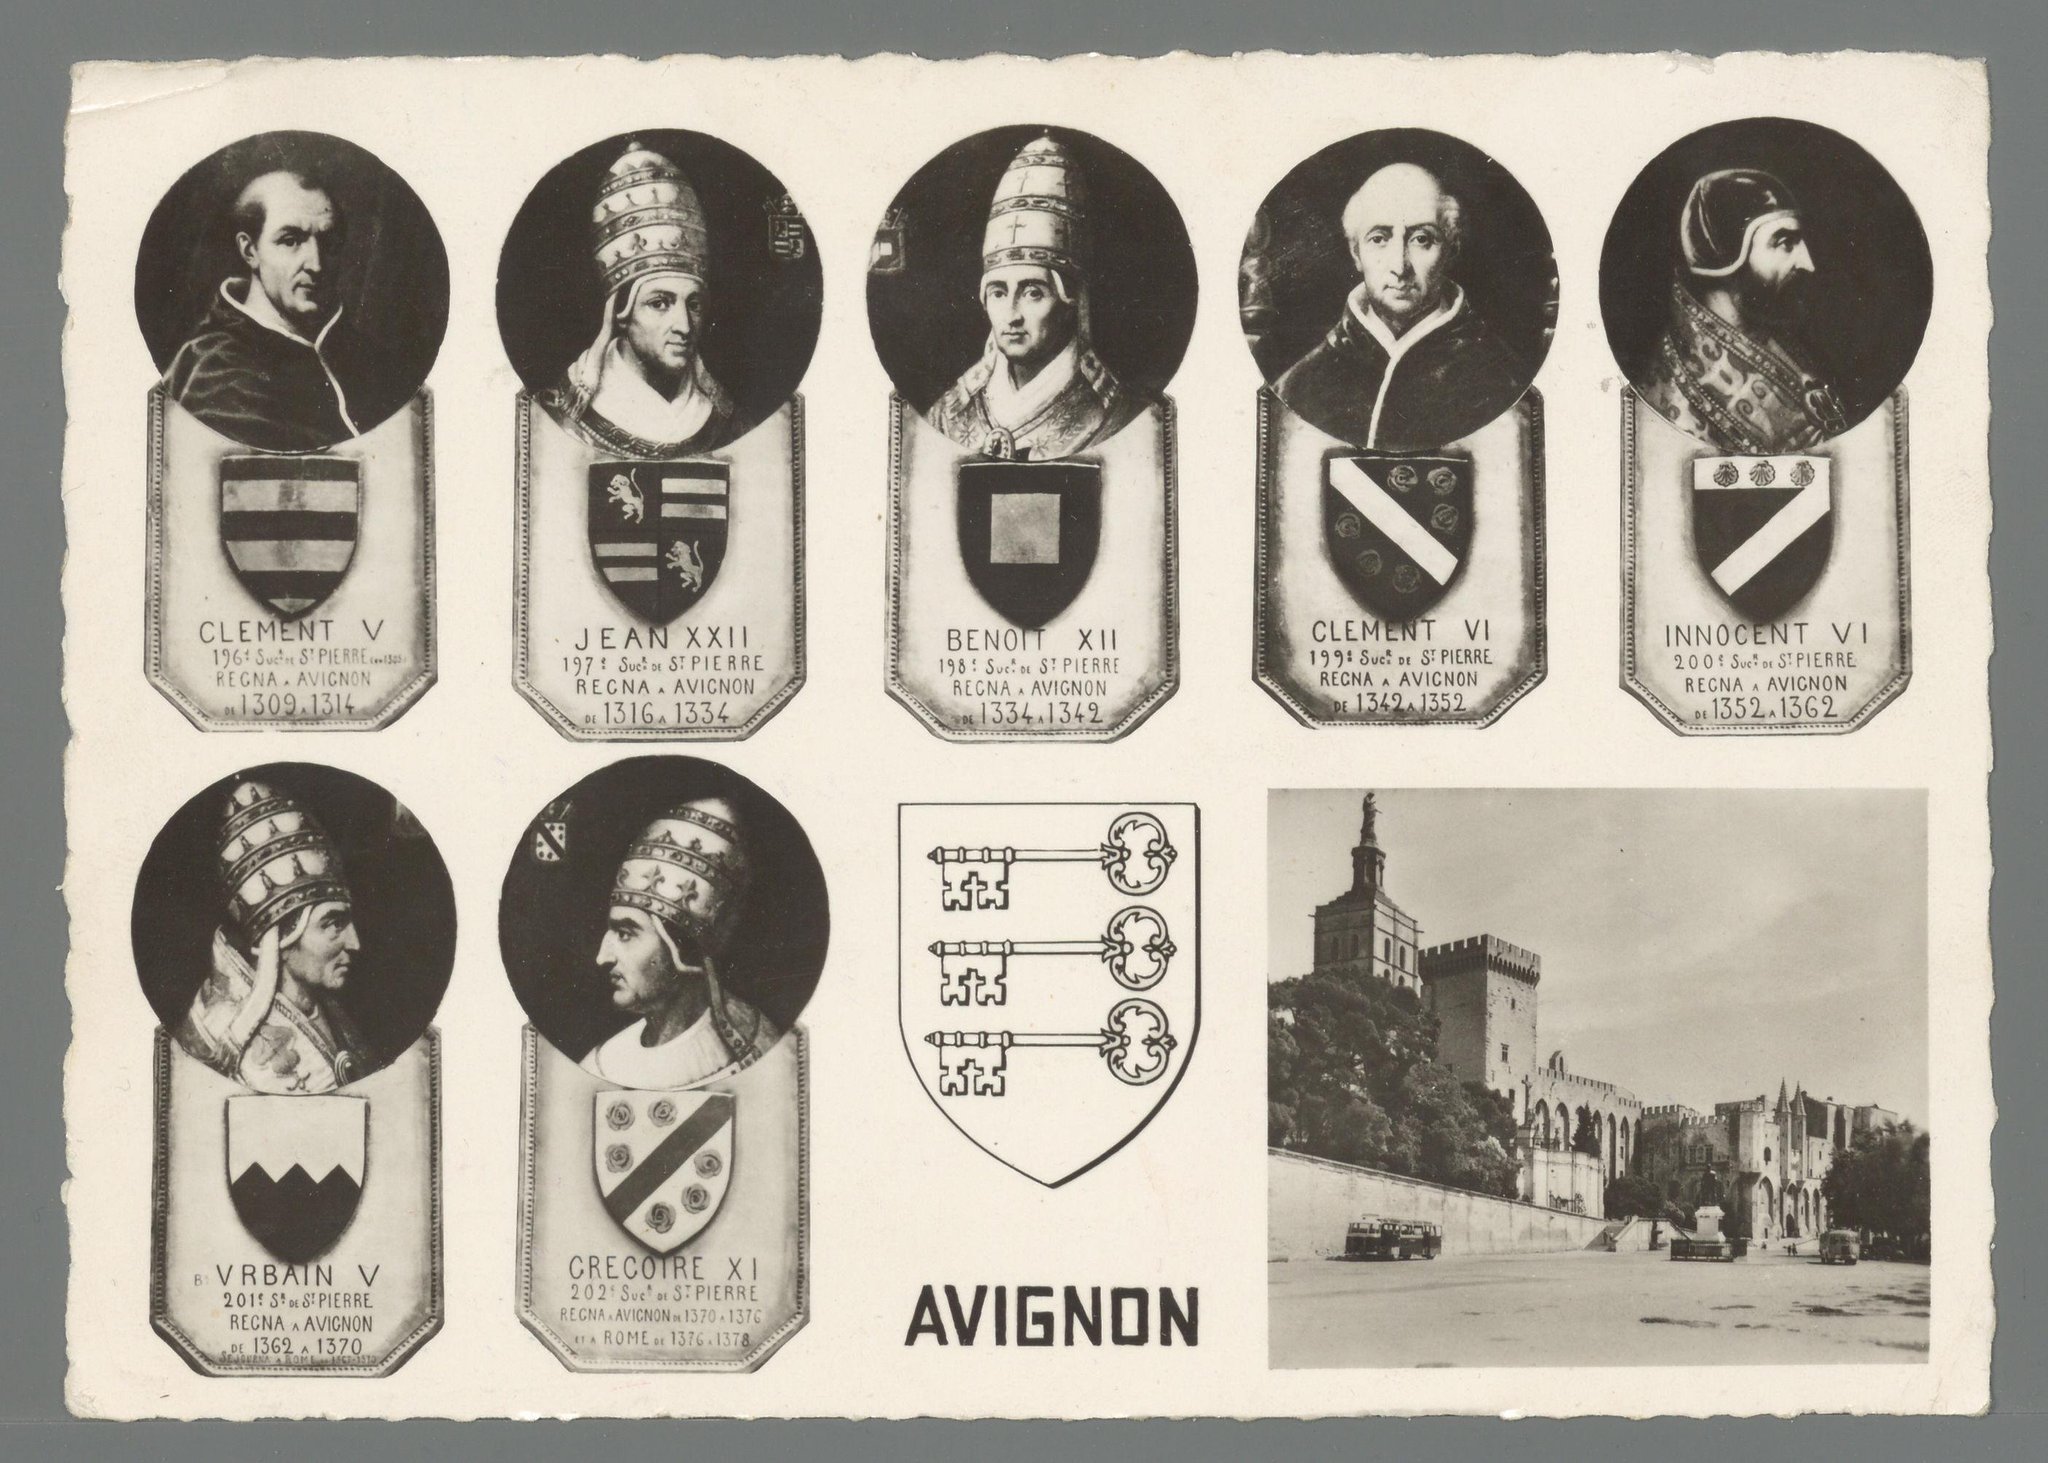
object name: ansichtkaart, prentbriefkaart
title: Avignon. Papes ayant régné en Avignon et armoiries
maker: Anonymous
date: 1932-1958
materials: photographic support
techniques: photography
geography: paris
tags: city-view, and landscape with man-made constructions, historical persons, pope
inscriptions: poststempel, verso, gestempeld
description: Dit is een foto van een collage van negen voorstellingen.